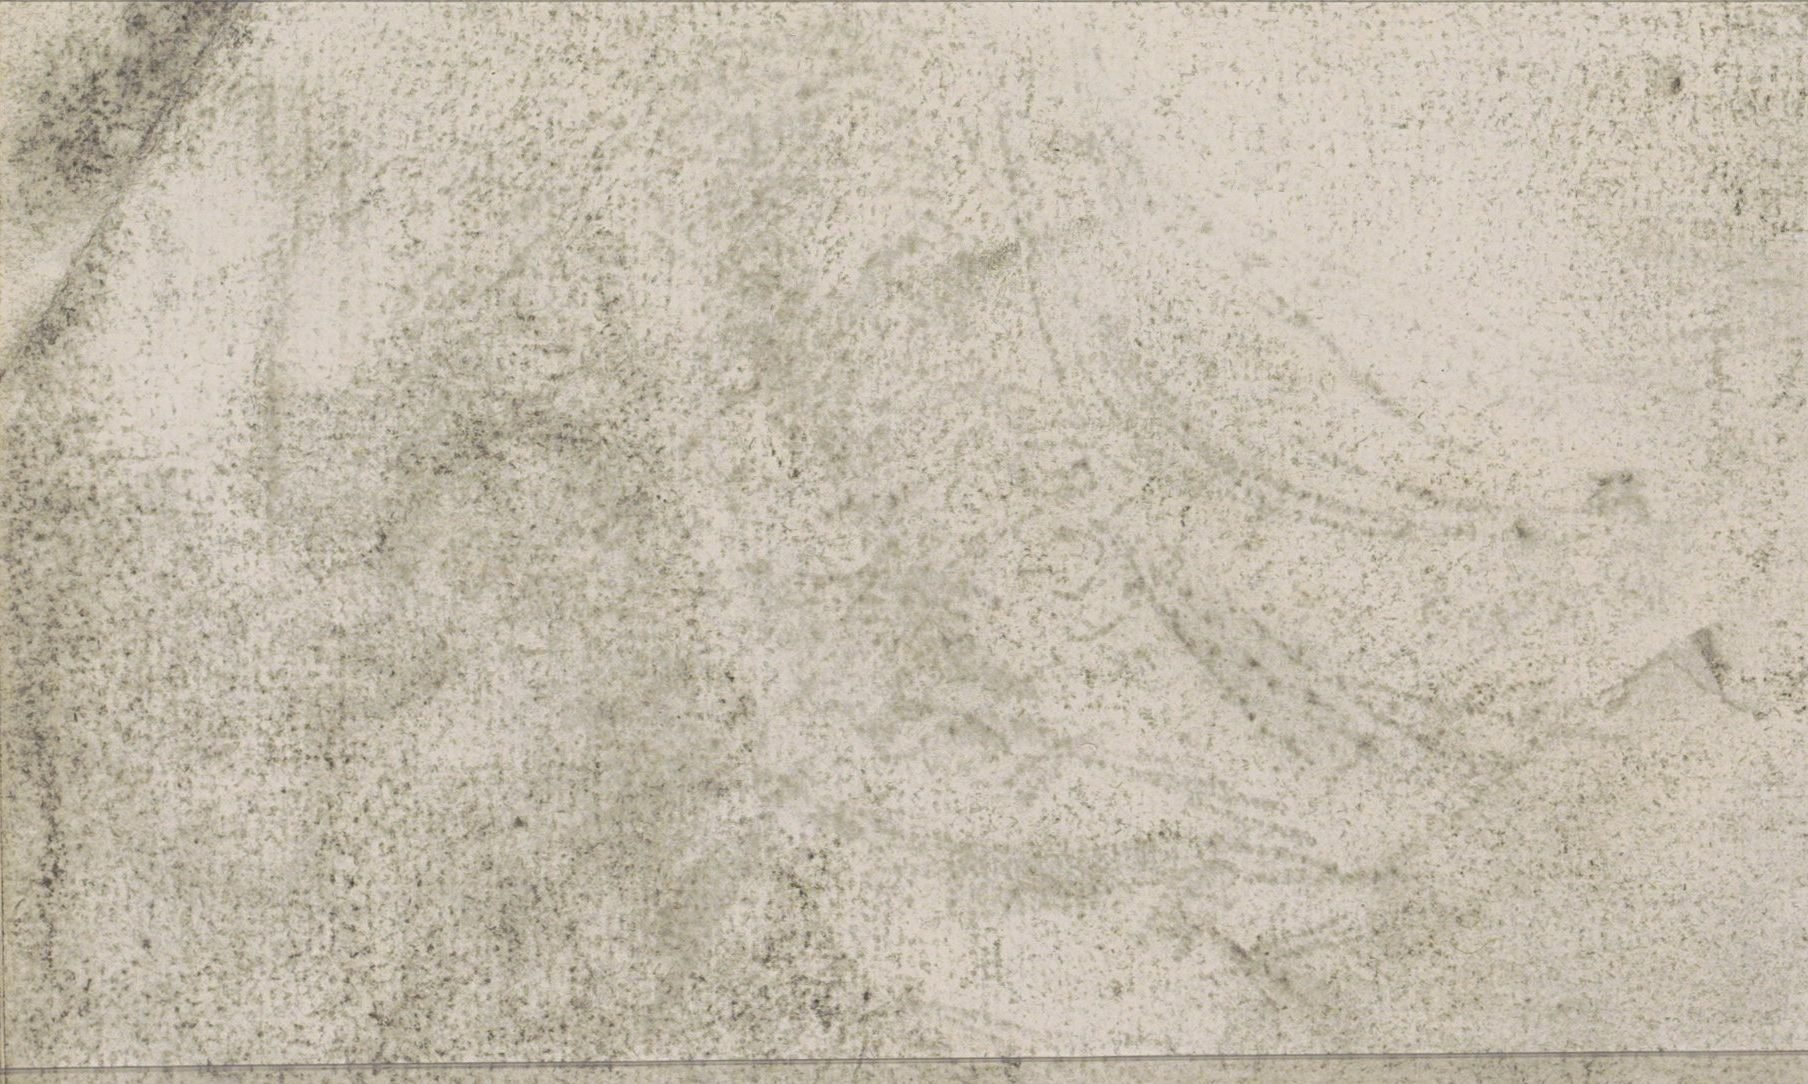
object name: sketchbook leaf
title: Abklatsch van de krijttekening op pagina 7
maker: isaac israels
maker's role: draughtsman, painter, print maker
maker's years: 1865-1934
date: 1875-1934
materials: paper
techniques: printmaking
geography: the hague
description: Pagina 6 uit schetsboek XLVIII met 62 pagina's.